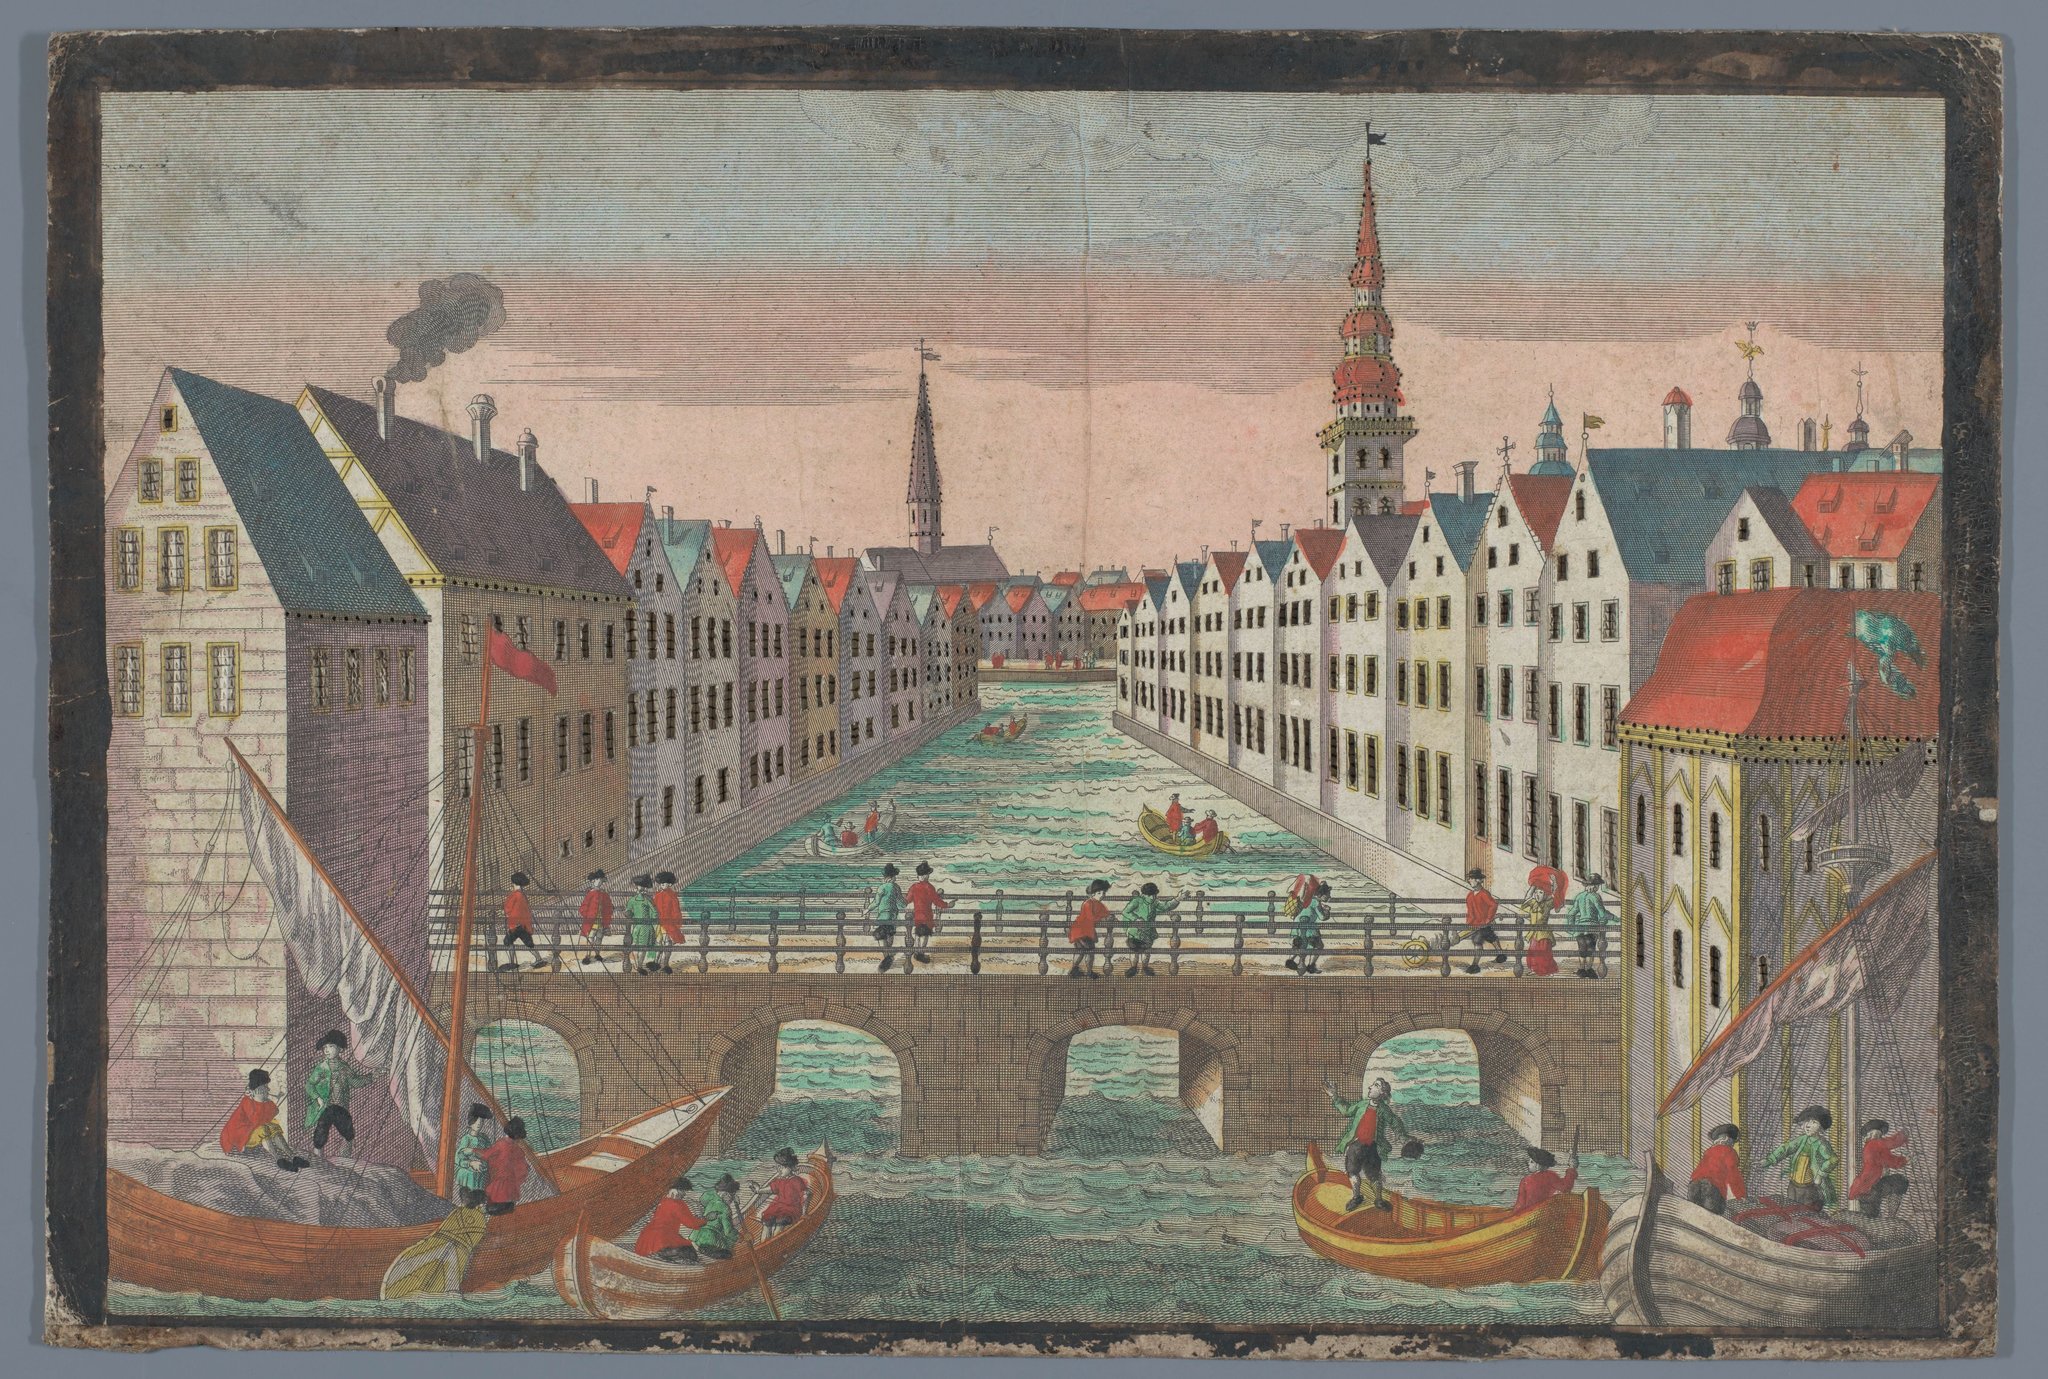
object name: opticaprent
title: Gezicht op de Nikolaifleet tegenover de Sankt Nikolaikirche te Hamburg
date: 1742-1801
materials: cardboard, paint, paper, watercolor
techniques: brush, cutting, etching, perforating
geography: augsburg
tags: bridge in city across river, canal, etc. (+ city(-scape) with figures, staffage), sailing-ship, sailing-boat, church (exterior), rowing-boat, canoe, etc., canals, waters (in city) (+ city(-scape) with figures, staffage)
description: Mogelijk rechtsboven genummerd geweest: 243. Mogelijk linksonder genummerd geweest: 59. De serie “Hamburg”, met het nummer 59, bevat vier prenten met de nummers 240-243, waarvan dit mogelijk nummer 243 is.